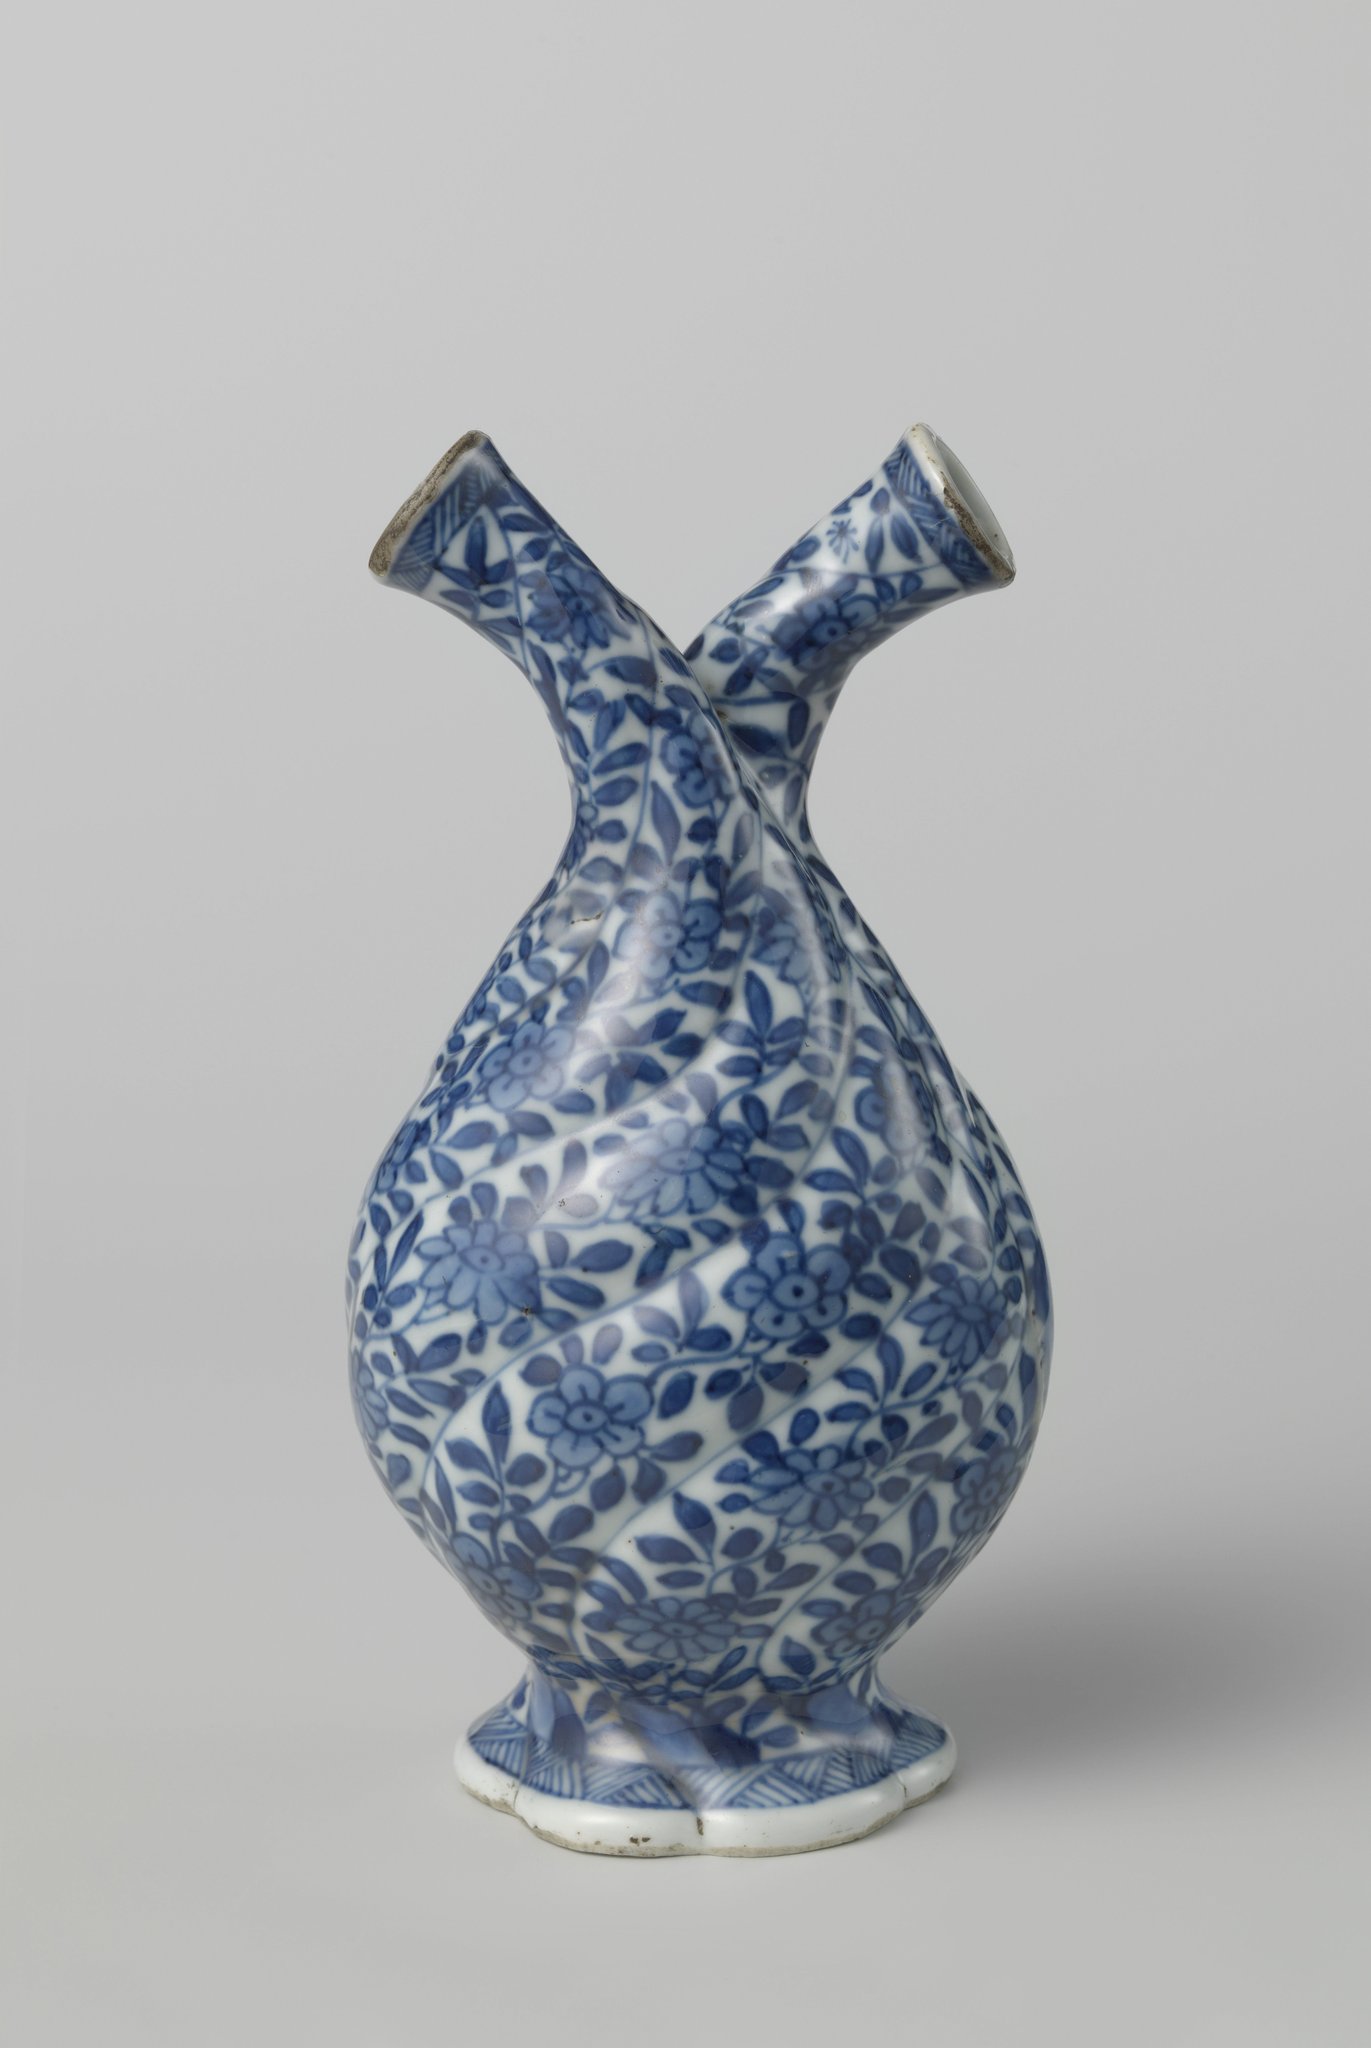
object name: oliefles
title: Double-bodied cruet with two spouts and flowerbands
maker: Anonymous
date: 1700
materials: cobalt, glaze, paint, porcelain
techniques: firing, forming, vitrification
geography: china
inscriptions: mark